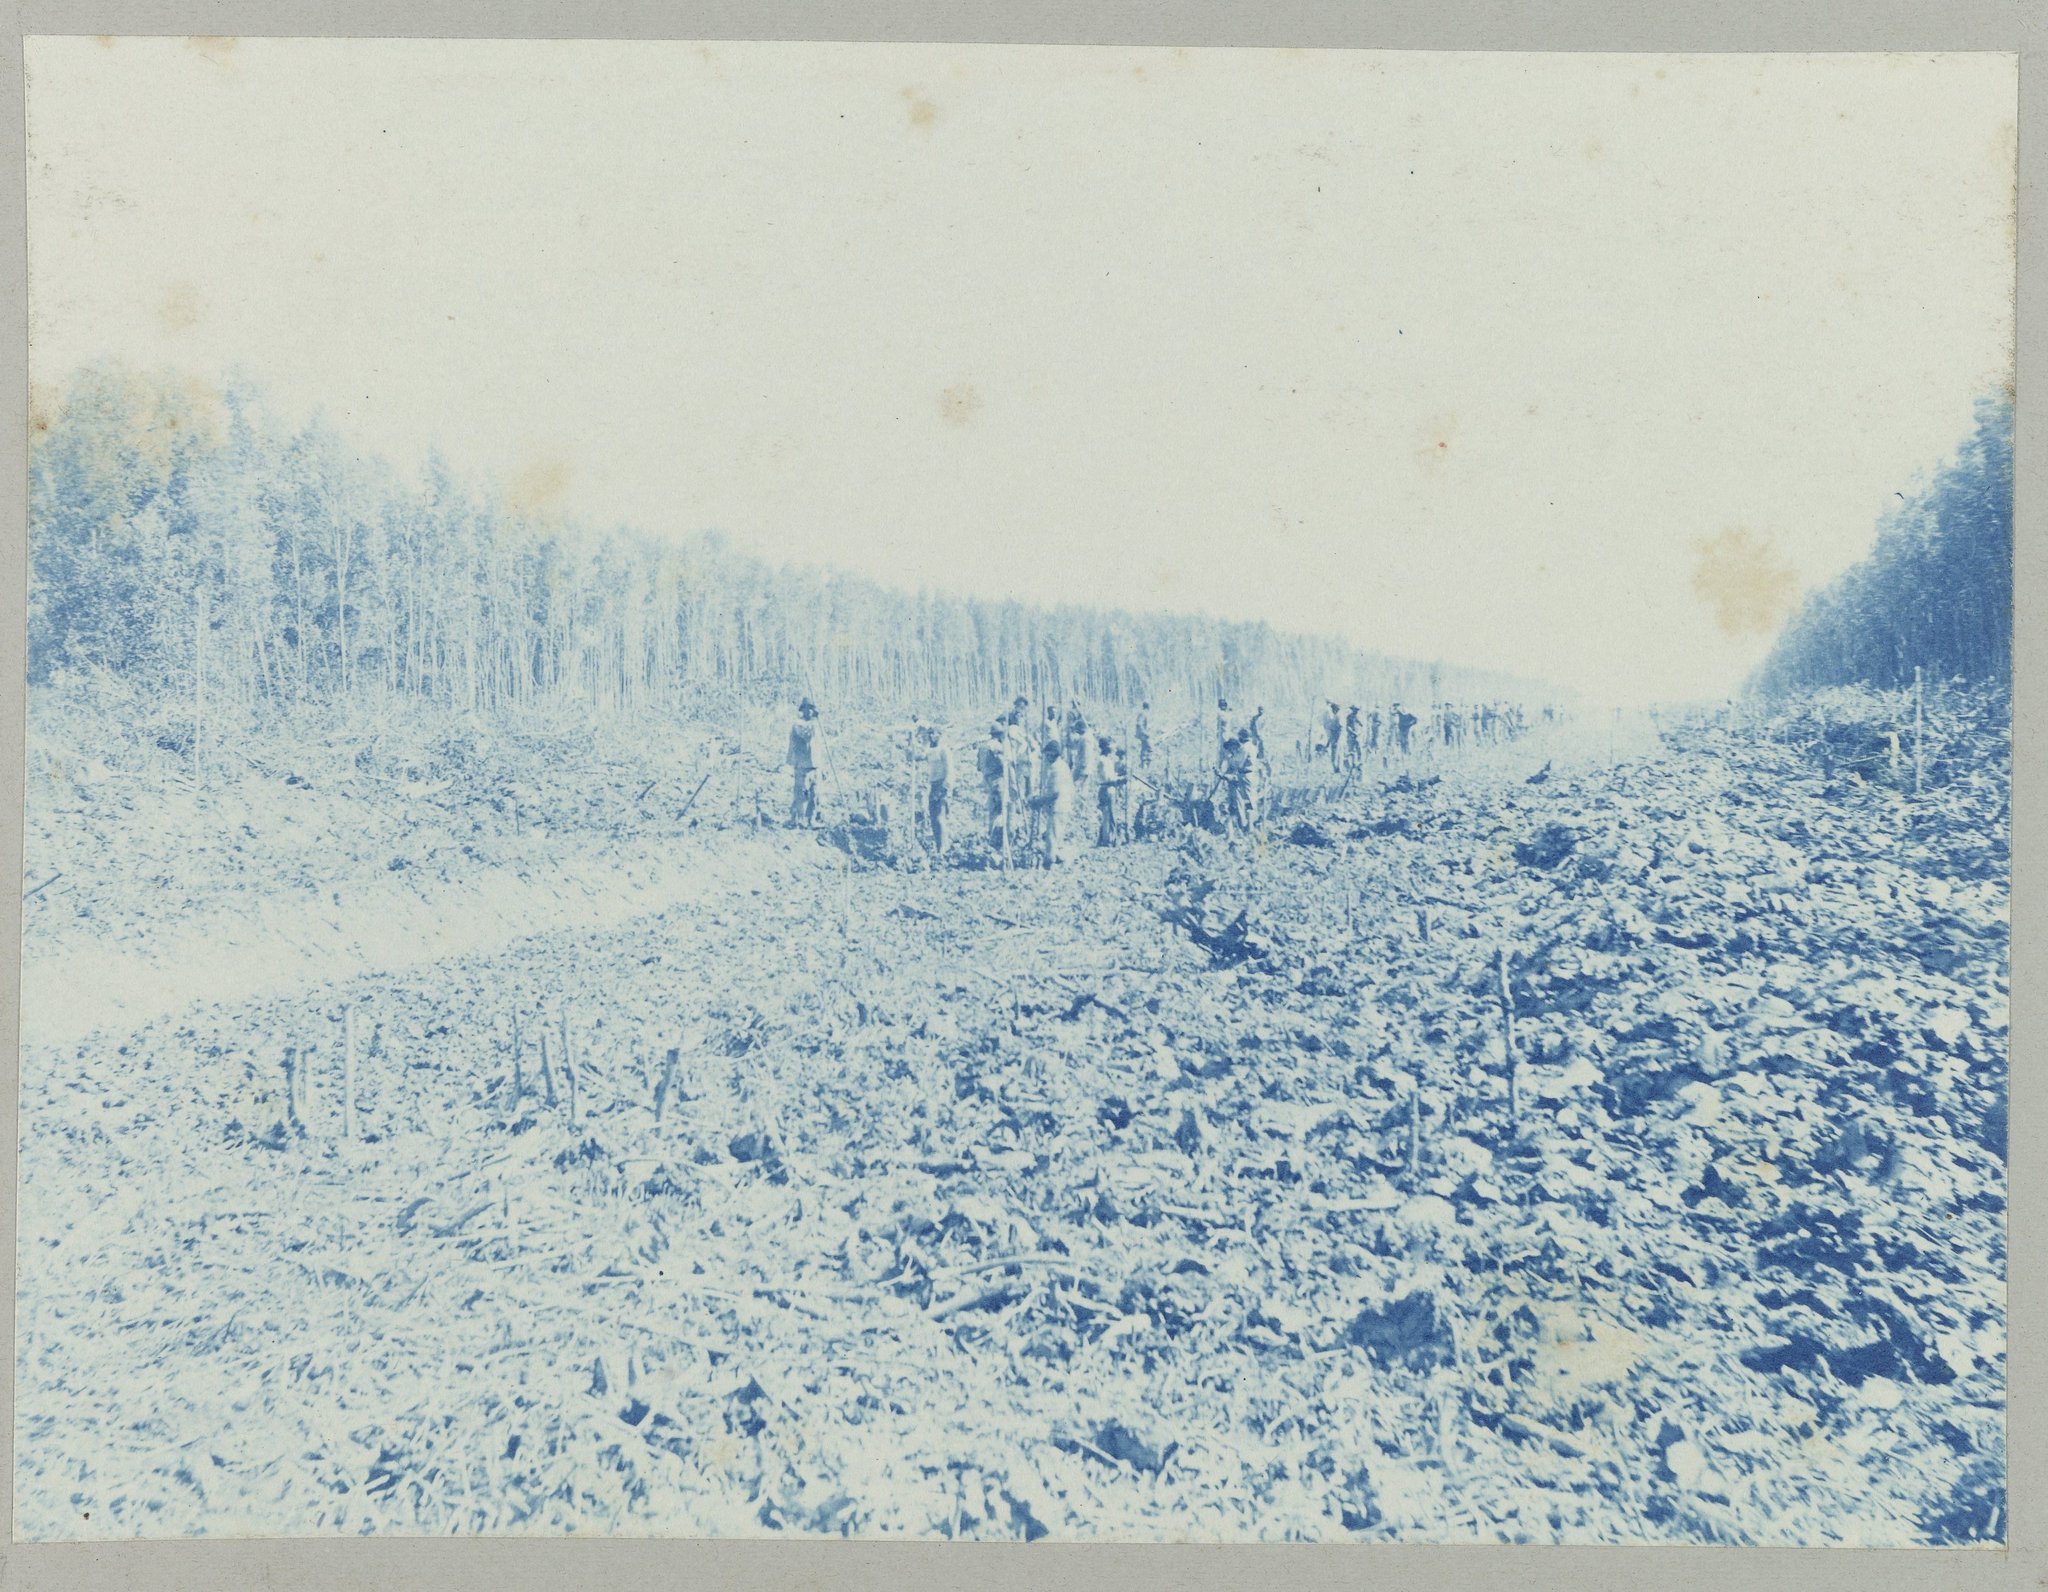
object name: photograph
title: Graven van nieuw zoutwaterkanaalvak op Totness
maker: hendrik doijer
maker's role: engineer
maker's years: 1863-1925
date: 1903-1910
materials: photographic support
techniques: cyanotype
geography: suriname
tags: suriname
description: Een grote groep arbeiders ingezet bij de graafwerkzaamheden voor een nieuw stuk van het zoutwaterkanaal van Totness. Onderdeel van het fotoalbum Souvenir de Voyage (deel 1), over het leven van de familie Doijer in en rond de plantage Ma Retraite in Suriname in de jaren 1903-1910.